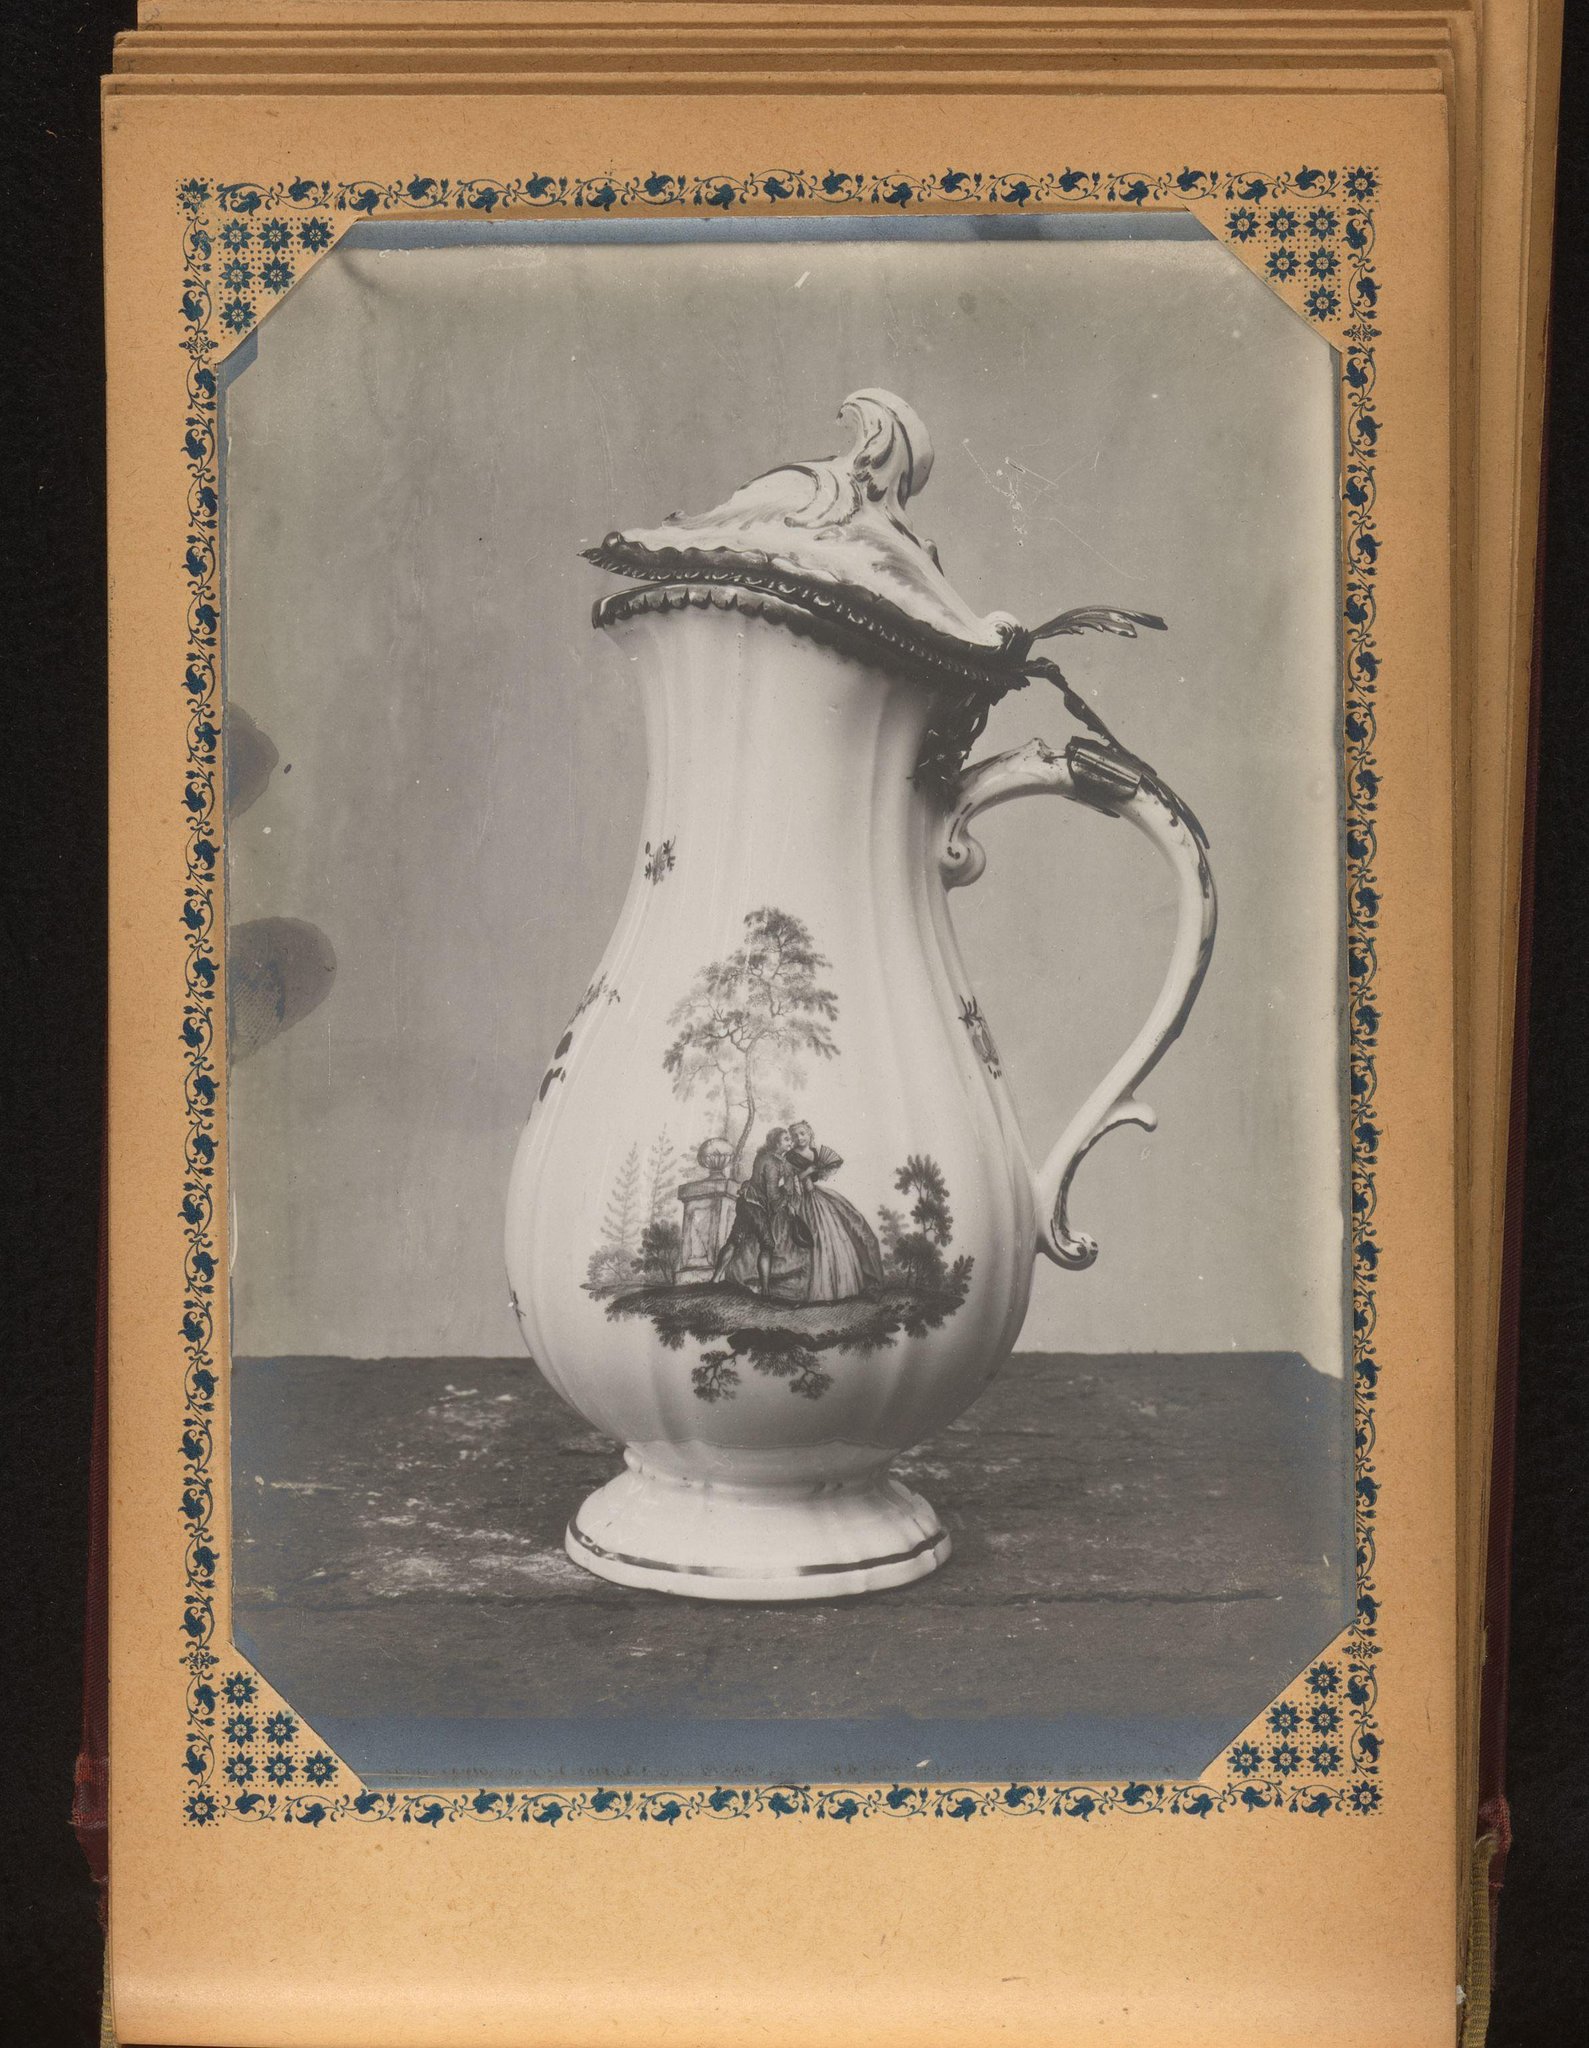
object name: album leaf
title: Kan beschilderd met een voorstelling van hofmakerij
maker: Anonymous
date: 1880-1940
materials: cardboard, photographic support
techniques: gelatin silver print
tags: courting, container of ceramics: jar, jug, pot, vase